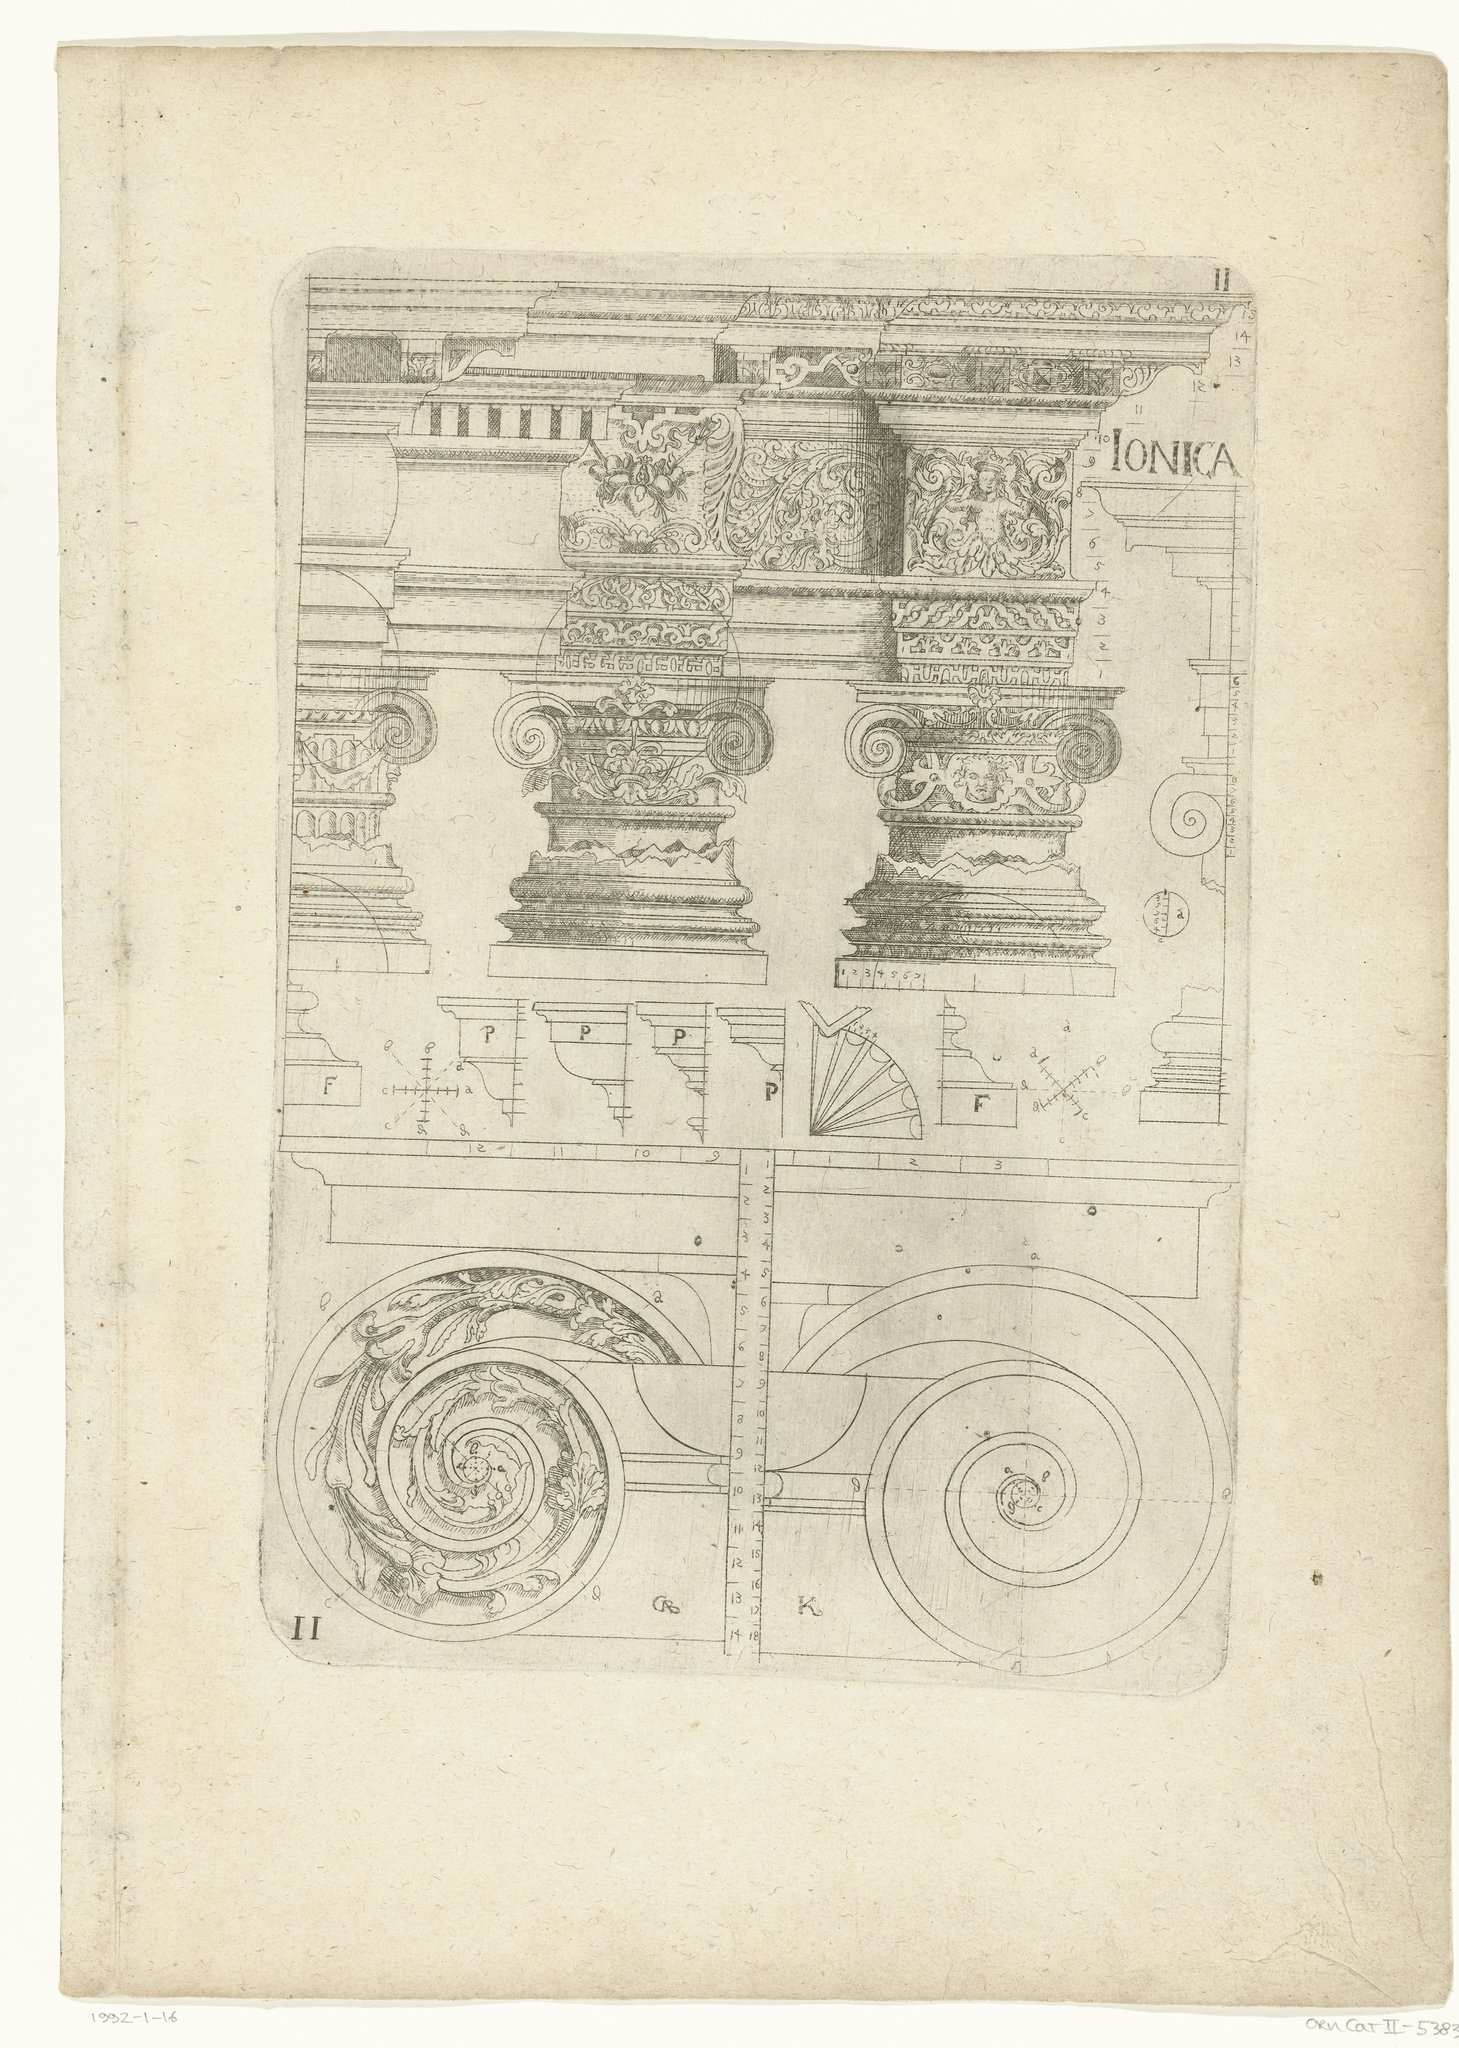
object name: print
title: Architectura von den funf Seuvlen (...)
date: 1610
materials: paper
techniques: etching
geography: germany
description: Onderaan twee helften van een Ionisch kapiteel. Blad 11 uit serie van titelblad en 28 bladen.